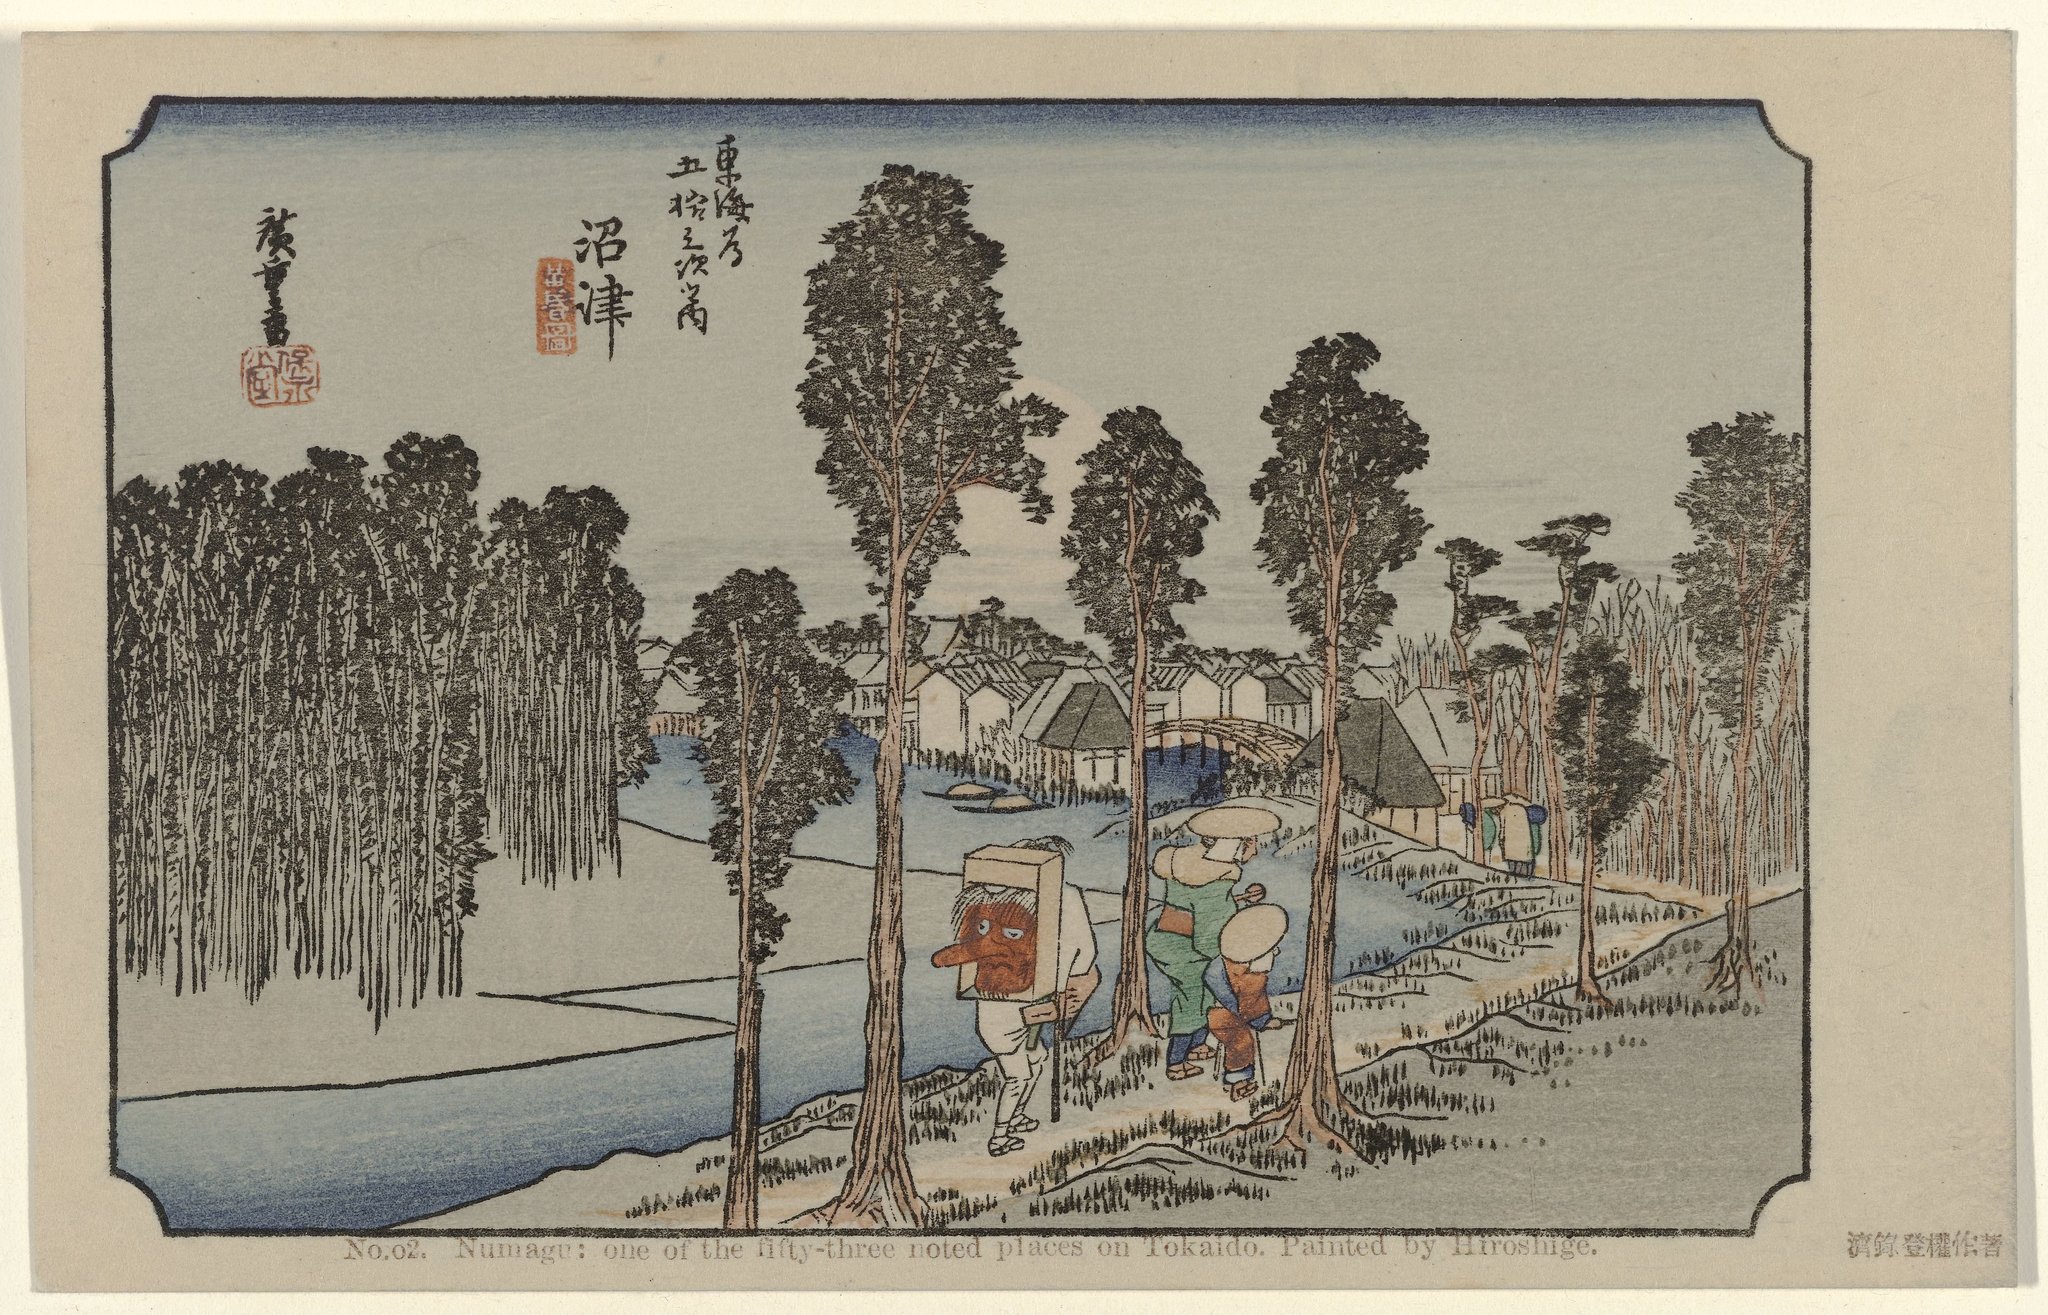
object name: ansichtkaart, prentbriefkaart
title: No. 13: Namazu: one of the fifty-three noted places on Tokaido. Painted by Hiroshige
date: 1906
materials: cardboard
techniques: woodcut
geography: japan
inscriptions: date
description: Reizigers wandelen langs een rivier, de achterste draagt een rood tengu masker op de rug.